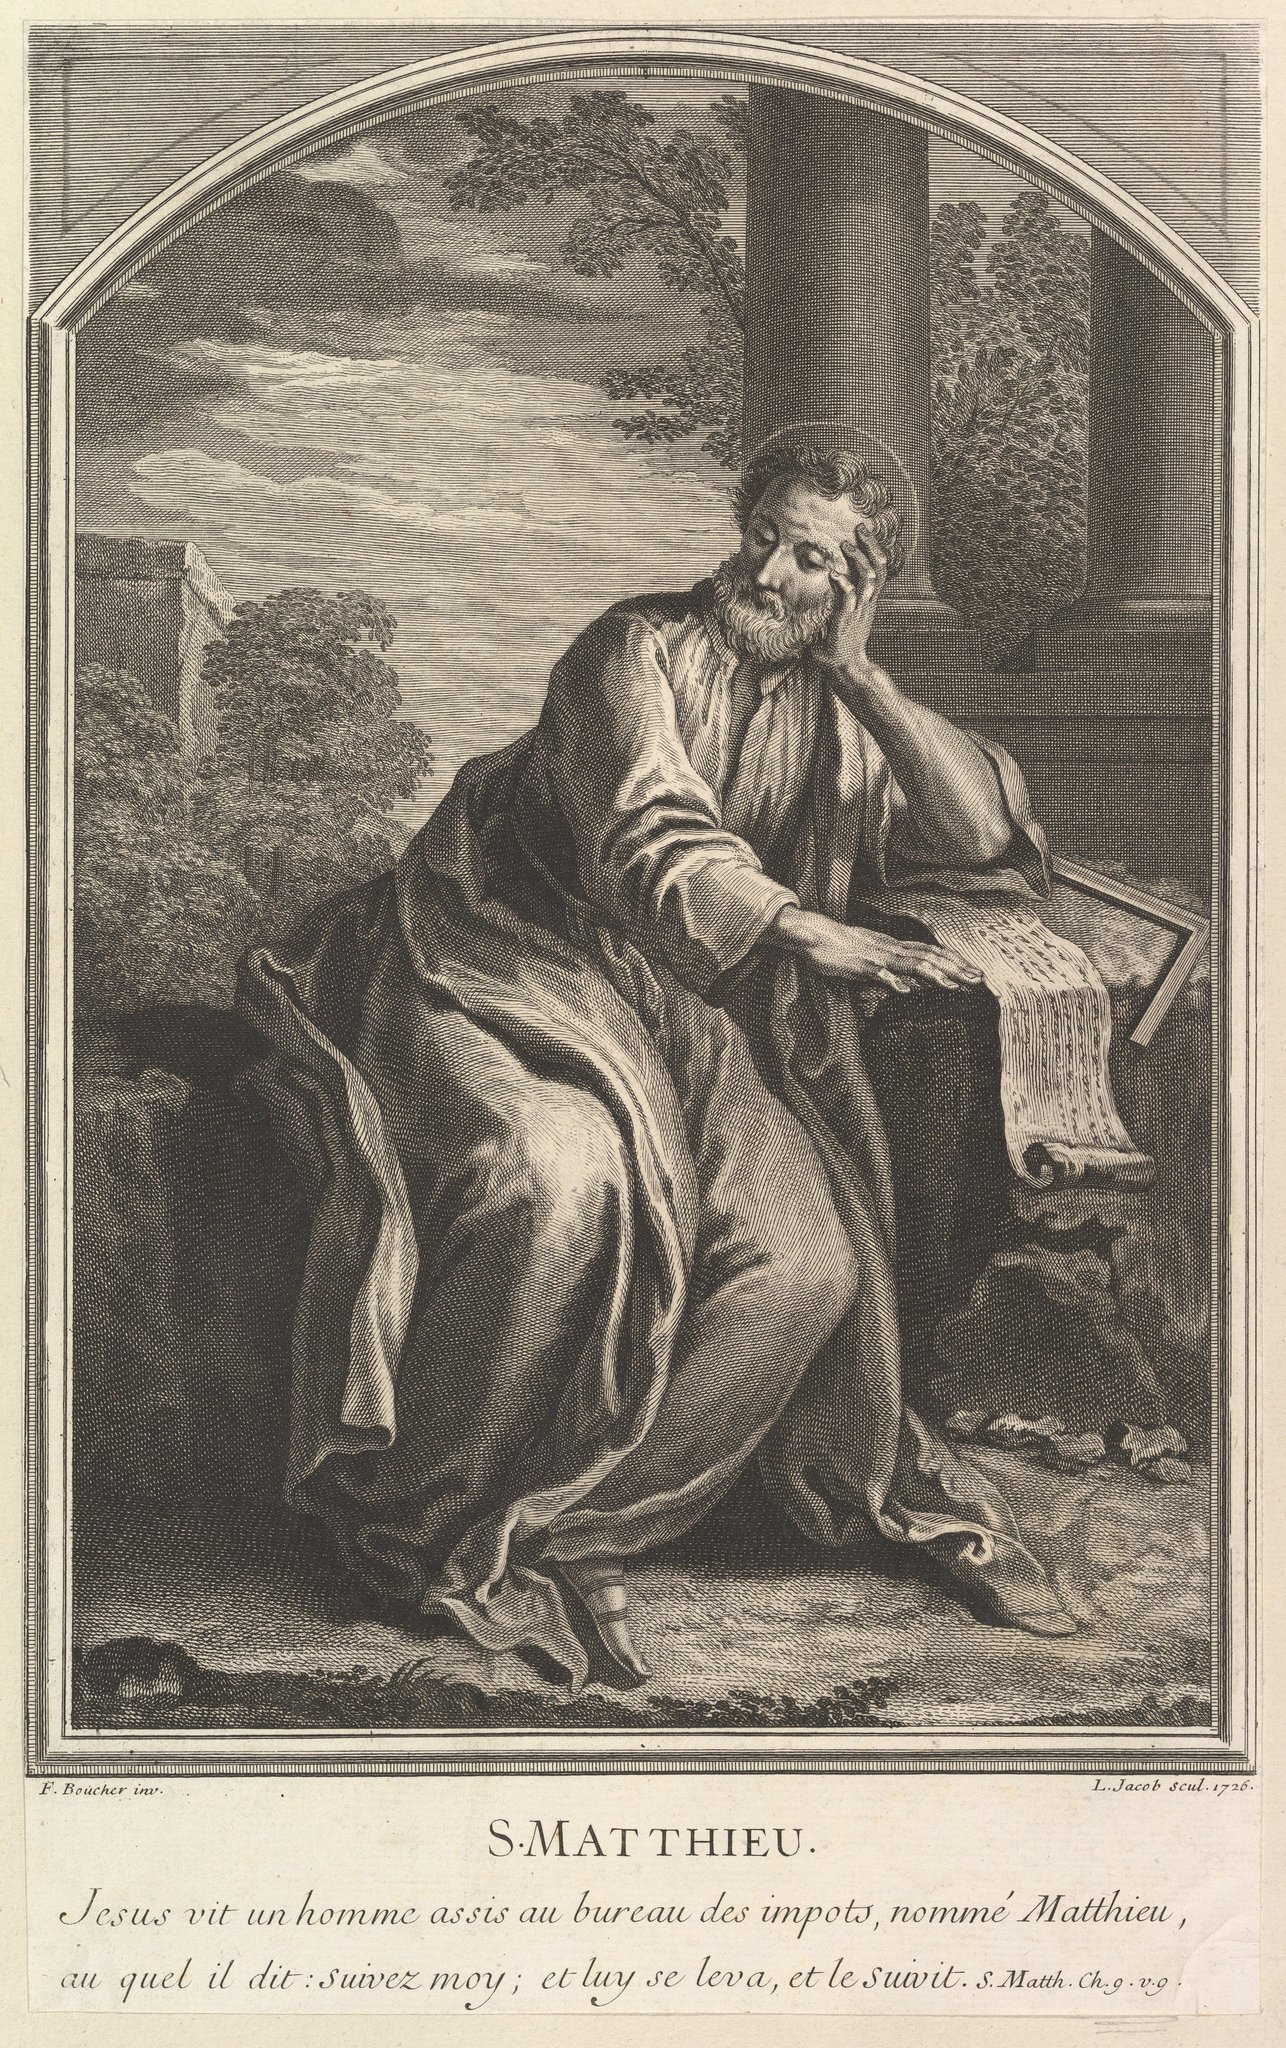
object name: print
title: Saint Mathew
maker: louis jacob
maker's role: artist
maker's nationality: french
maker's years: 1712-1802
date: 1726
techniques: engraving, etching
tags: men,saints